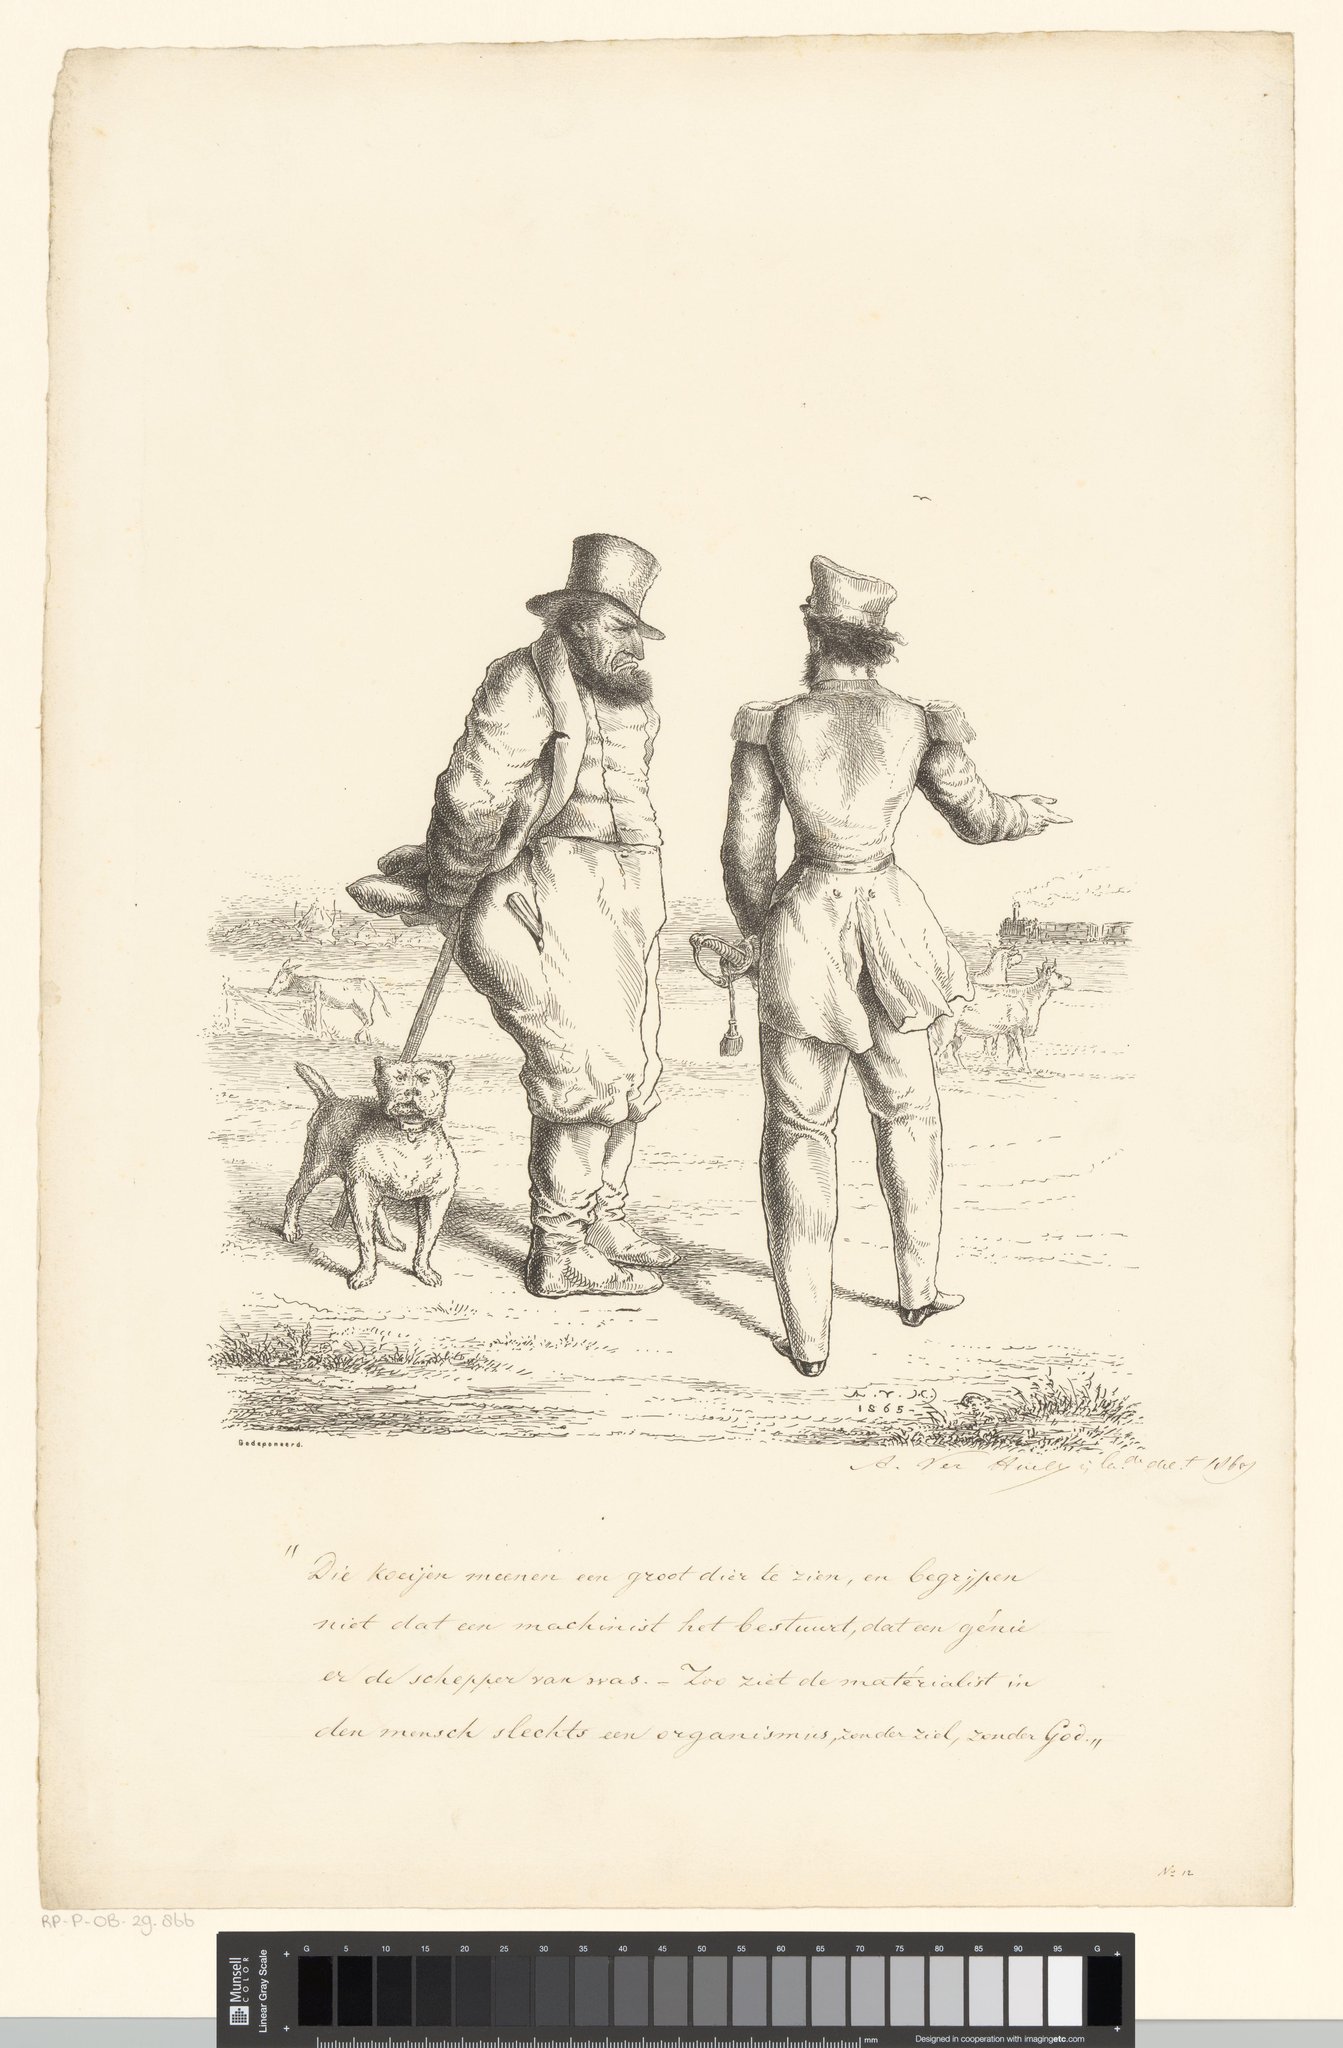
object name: print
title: Twee mannen in gesprek over de trein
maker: alexander ver huell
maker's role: draughtsman, print maker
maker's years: 1822-1897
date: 1864-1866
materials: paper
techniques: lithograph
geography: arnhem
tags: railway, train, conversation, dialogue; conversation piece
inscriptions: : ‘Gedeponeerd.’, collector's mark: Lugt 2228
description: Een oude man met hond is in gesprek met een man op de rug gezien. Zij praten over de trein die in de achtergrond rijdt.